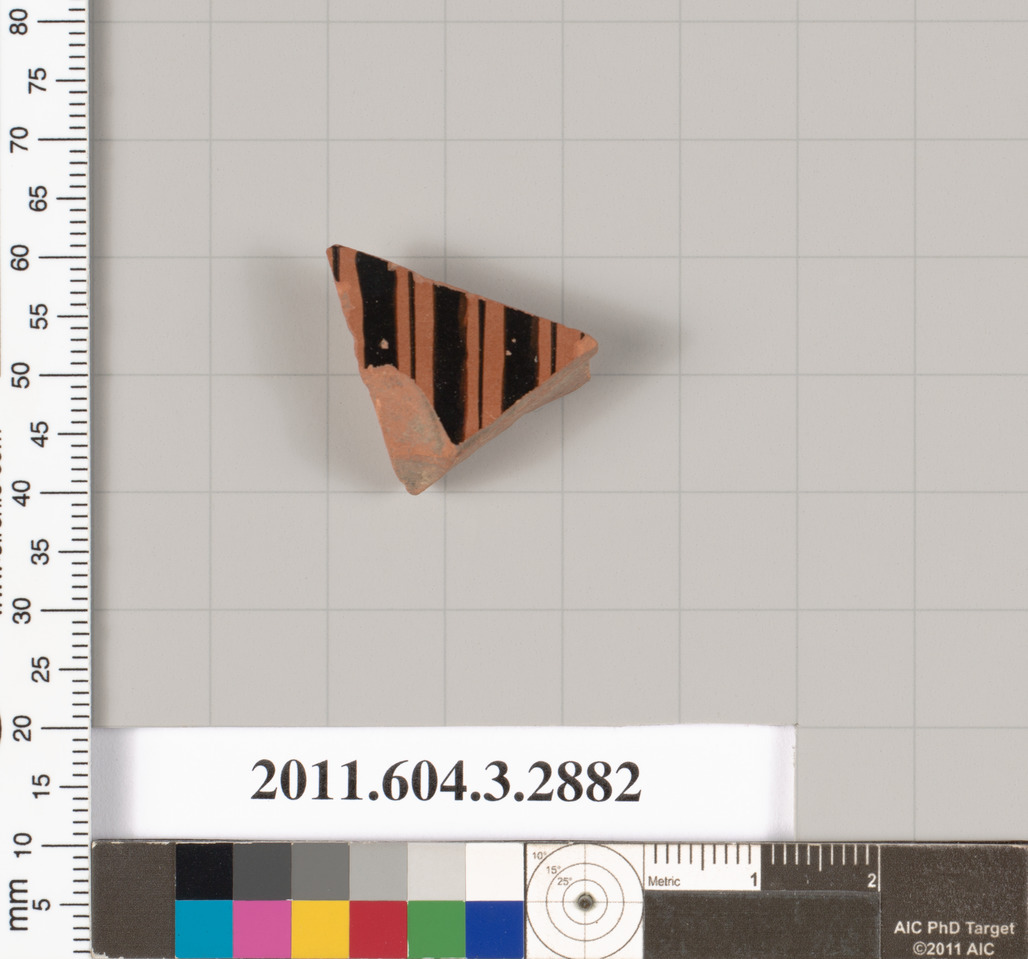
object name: undetermined closed shape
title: Terracotta fragment of a closed shape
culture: greek, attic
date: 600-401 BCE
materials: terracotta